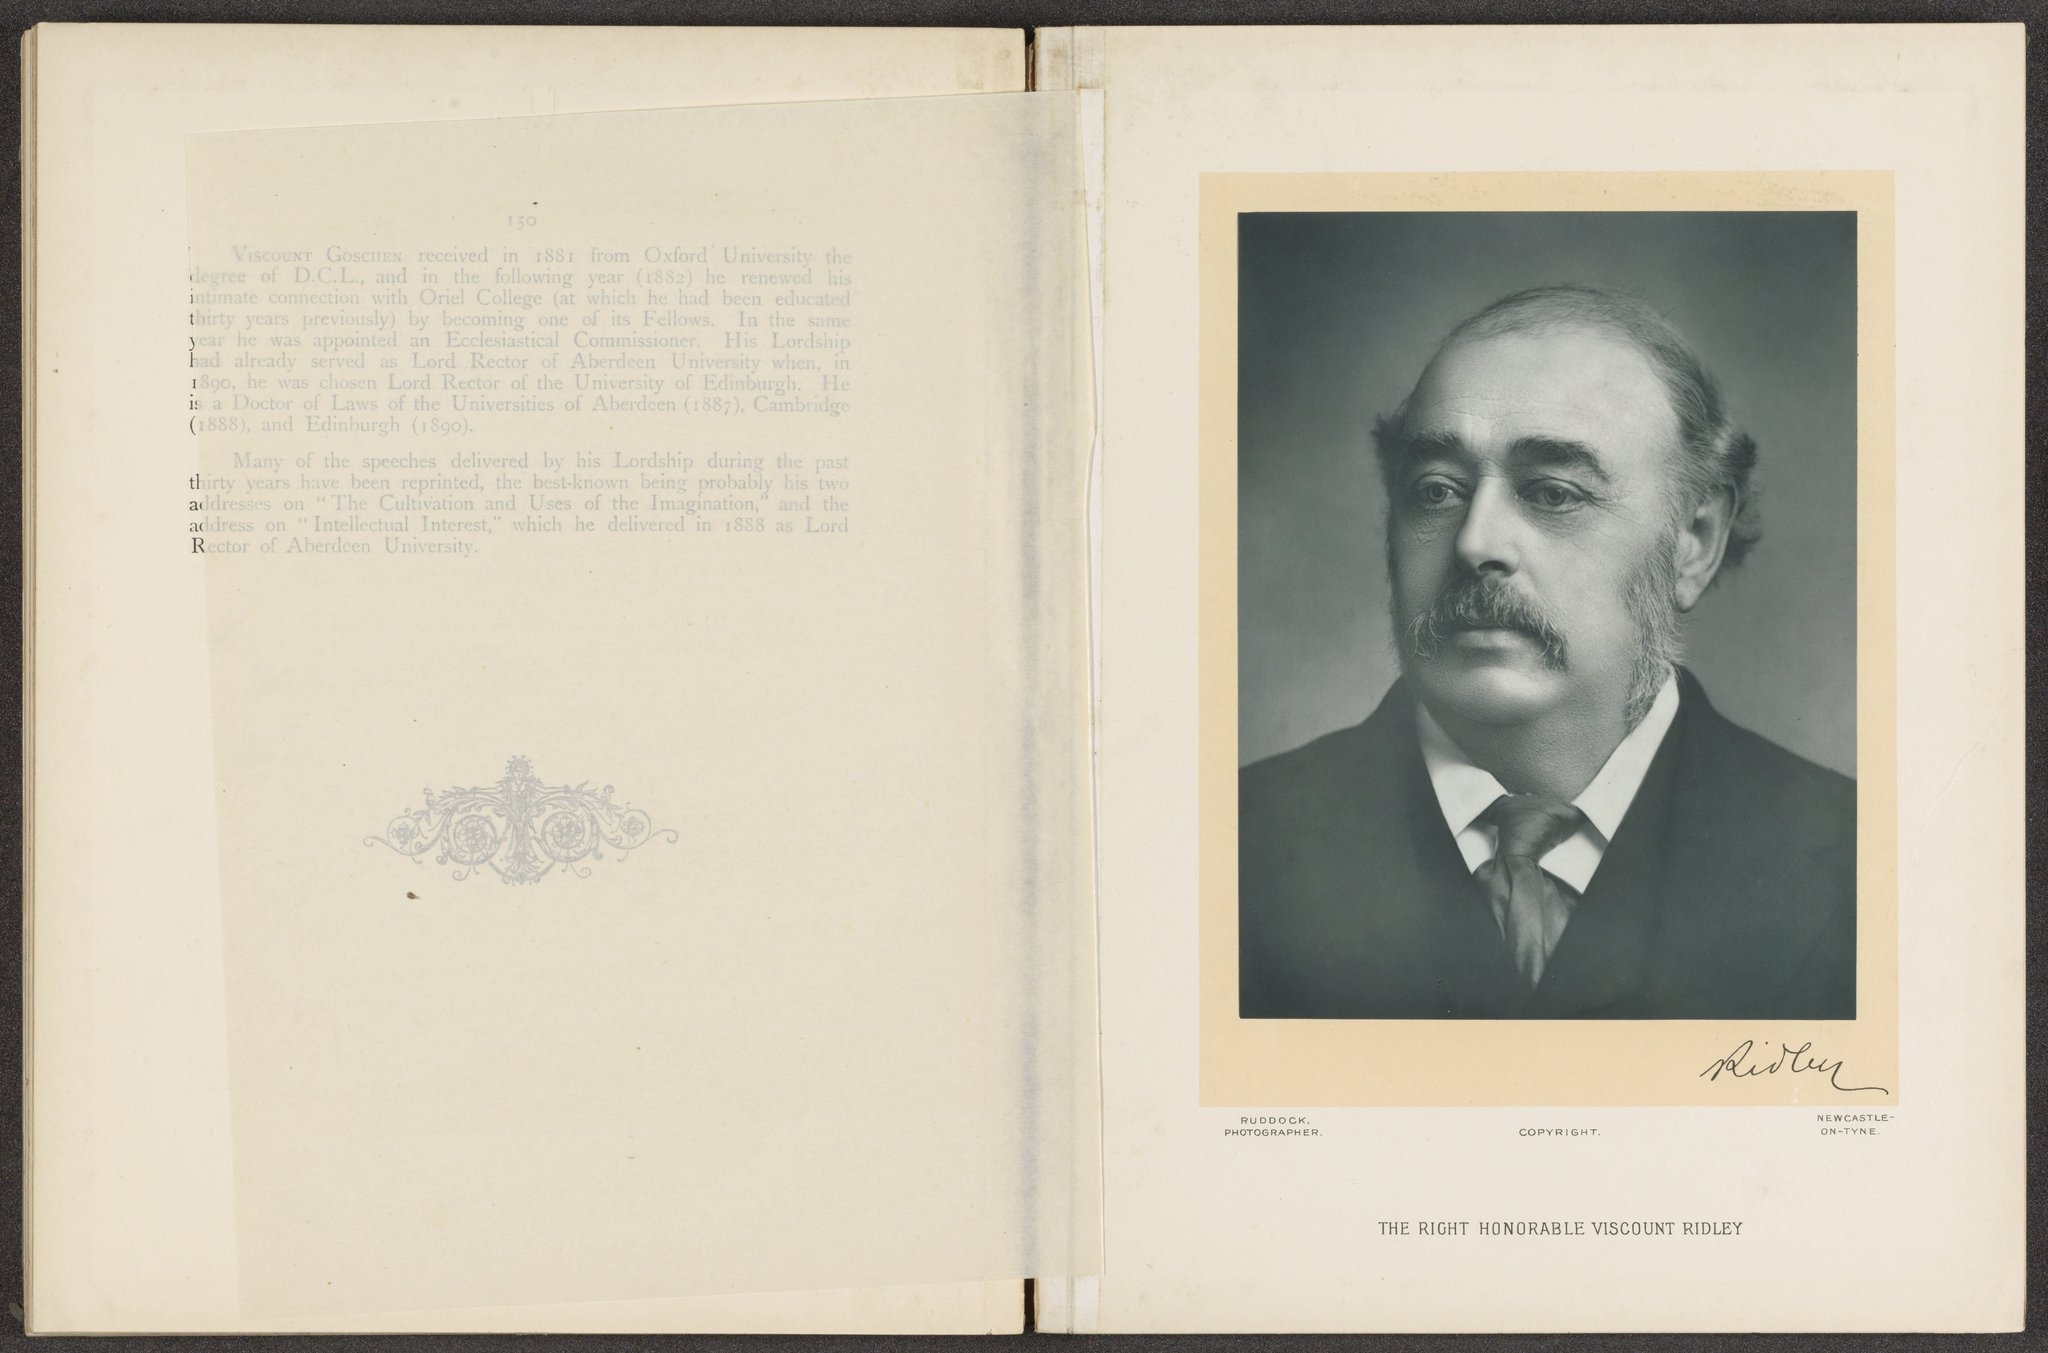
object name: page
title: The right honorable Viscount Ridley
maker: ruddock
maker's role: fotograaf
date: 1893-1903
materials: paper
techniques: carbon print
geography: london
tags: historical persons (portraits and scenes from the life) (+ (full) bust portrait)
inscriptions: annotation, inscription: ‘Newcastle-on-Tyne’